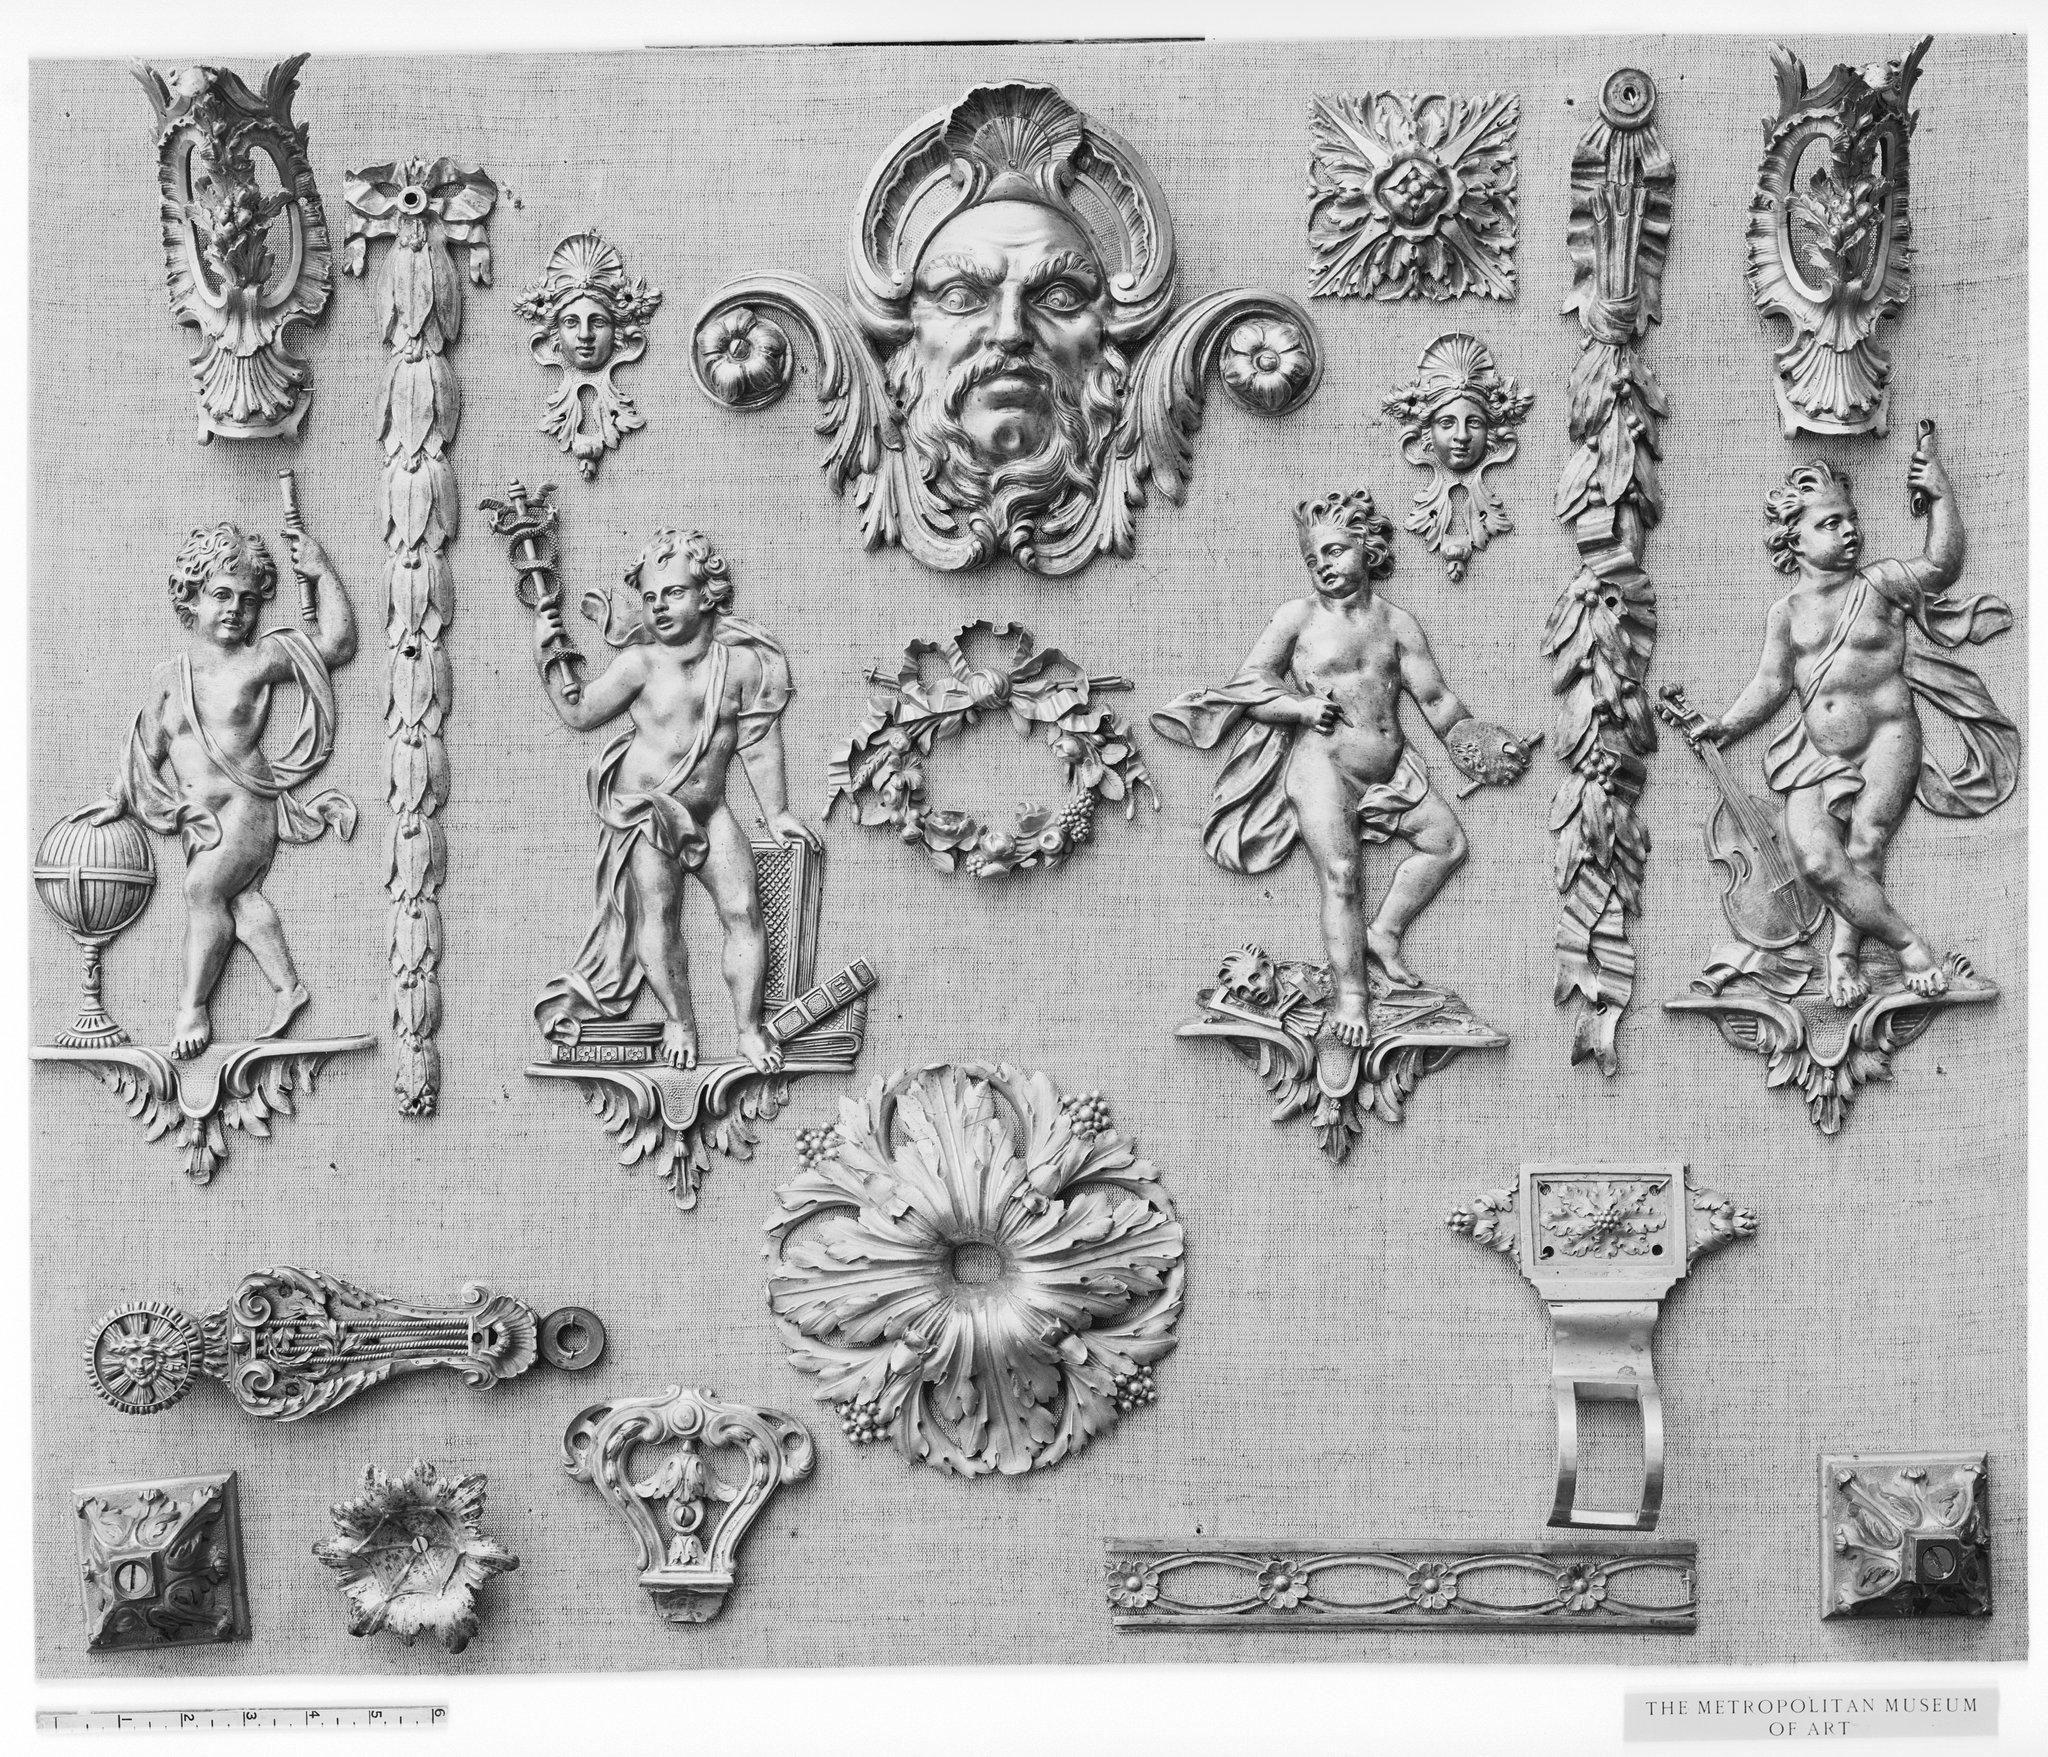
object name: corner mount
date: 1701-1800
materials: gilt bronze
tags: musical instruments,faces,boys,men,globes